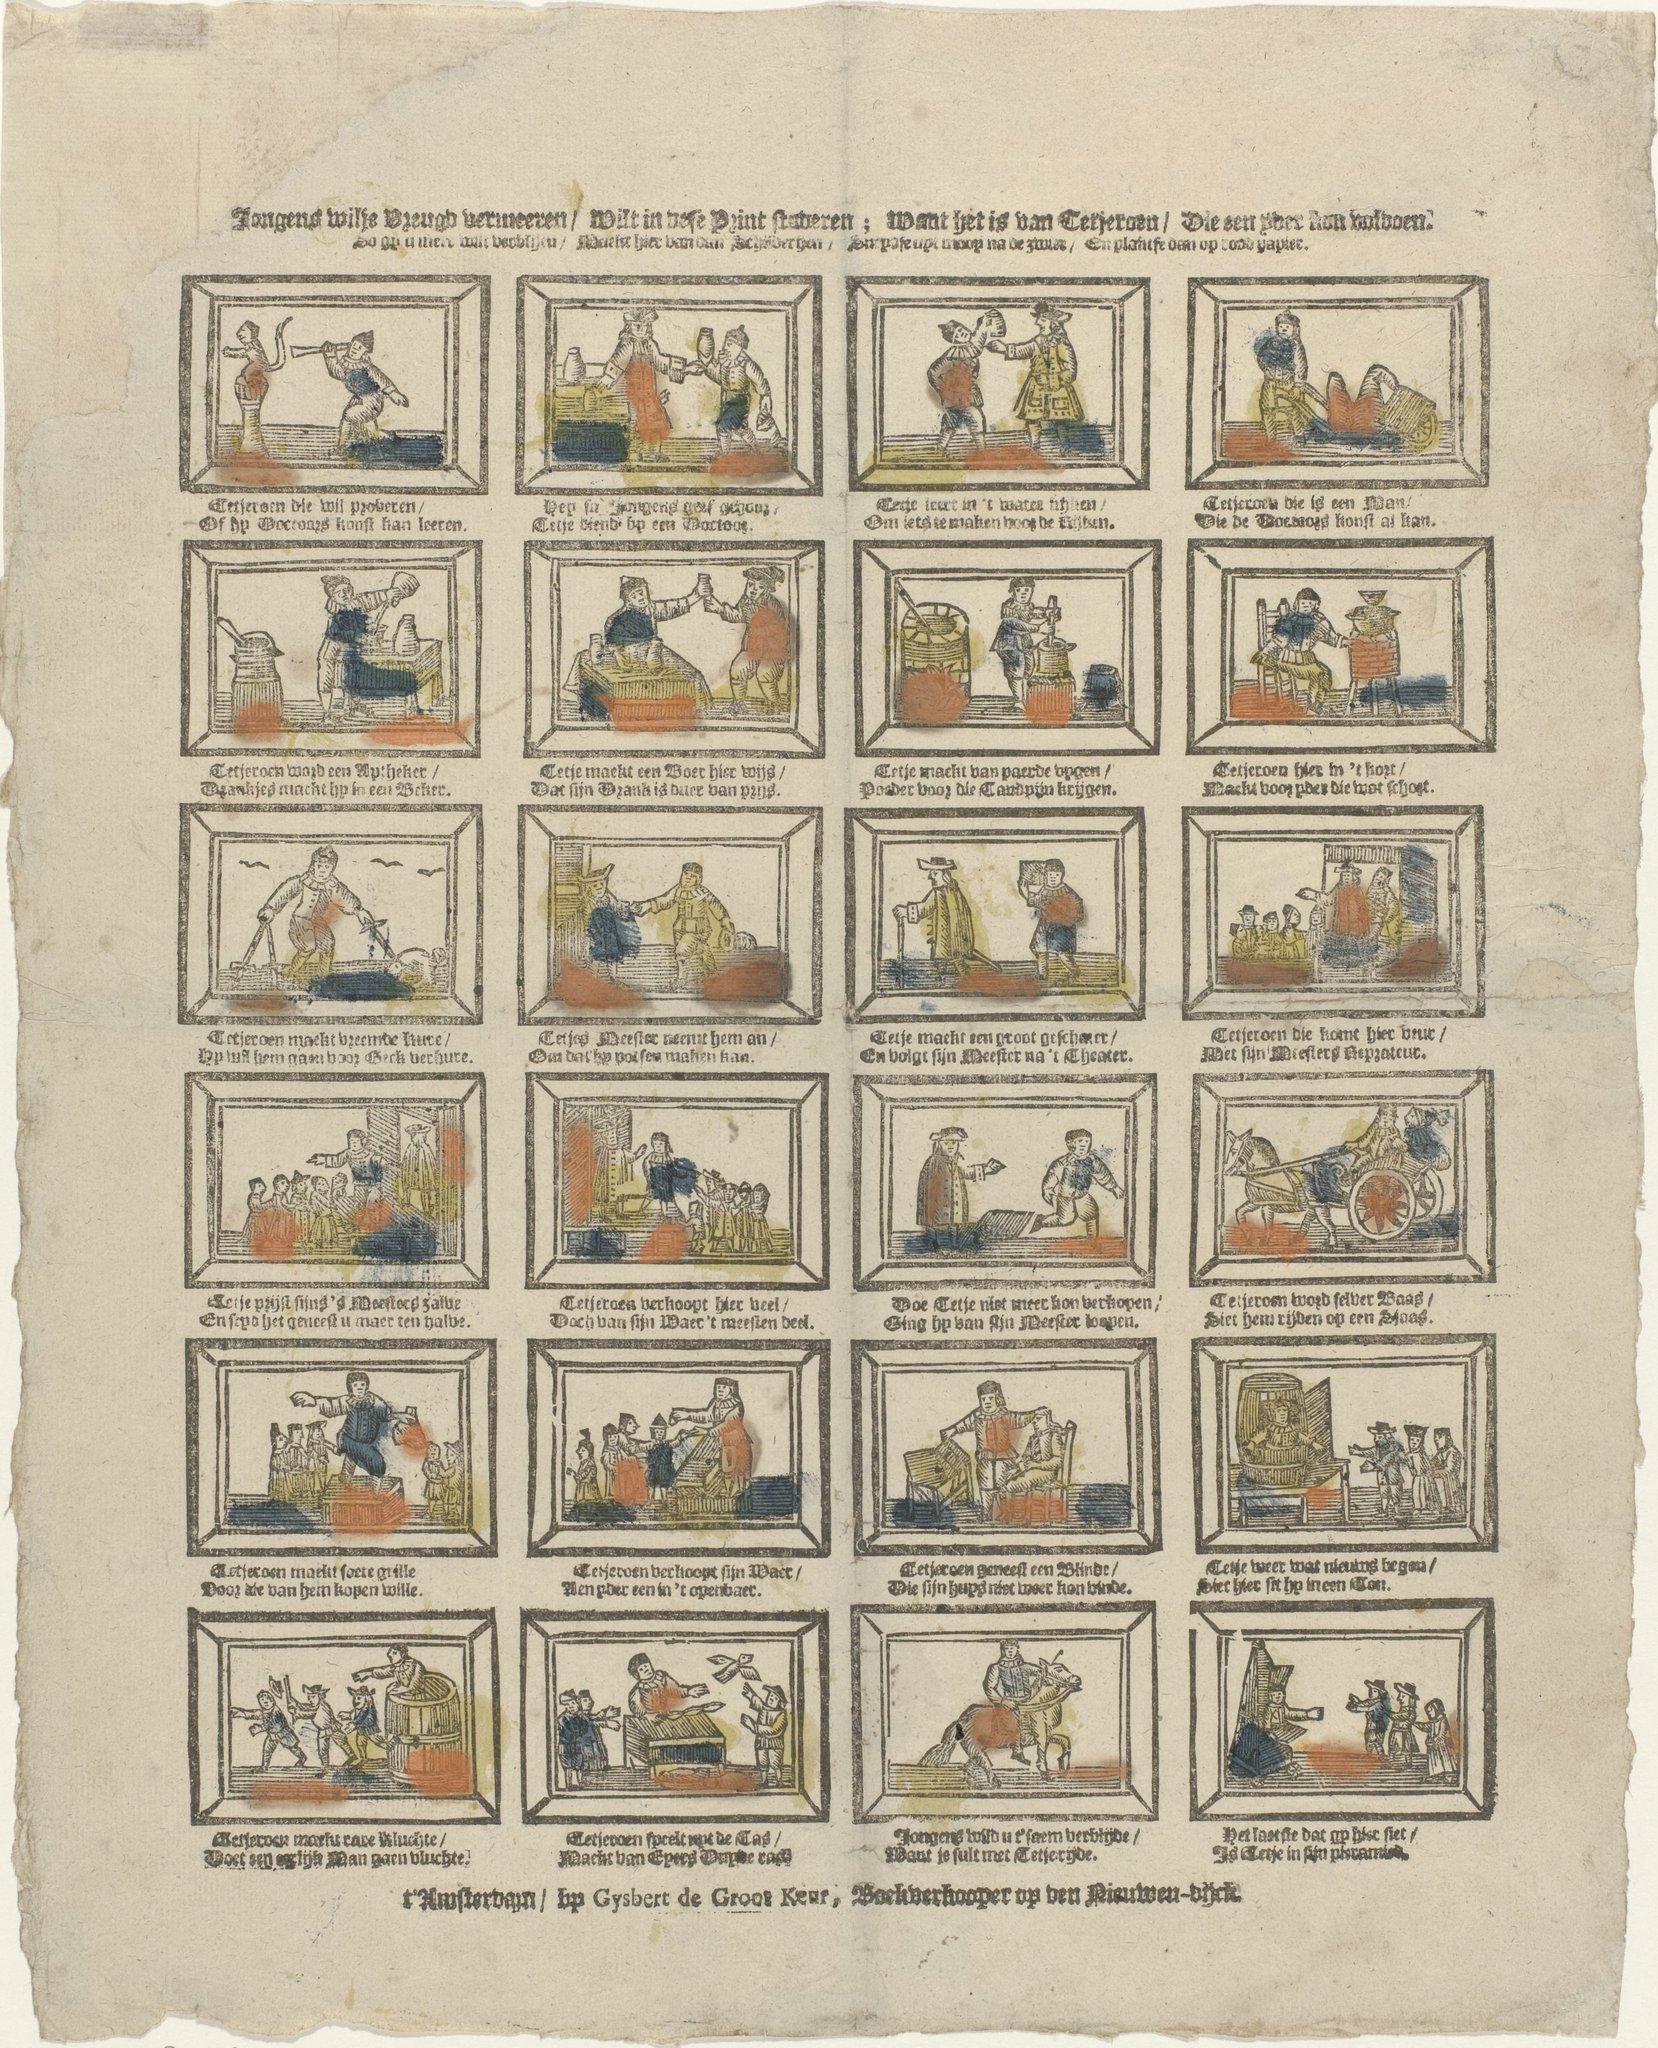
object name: print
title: Jongens wilje Vreugd vermeeren / wilt in dese print studeren; Want het is van Tetjeroen / Die eenyder kon voldoen (...)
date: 1738-1767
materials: paper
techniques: colour, letterpress printing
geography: amsterdam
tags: quack, charlatan, mountebank, 'saltimbanco', passenger carriage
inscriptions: collector's mark: Lugt 2760, collector's mark: Lugt 2228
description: Blad met 24 voorstellingen over het leven van de kwakzalver en grappenmaker Tetjeroen. Hij gaat in de leer bij een dokter, klopt boeren geld uit de zak, kookt drankjes van paardenvijgen en gaat met zijn liefje in een koets rijden. Onder elke afbeelding een tweeregelig vers.